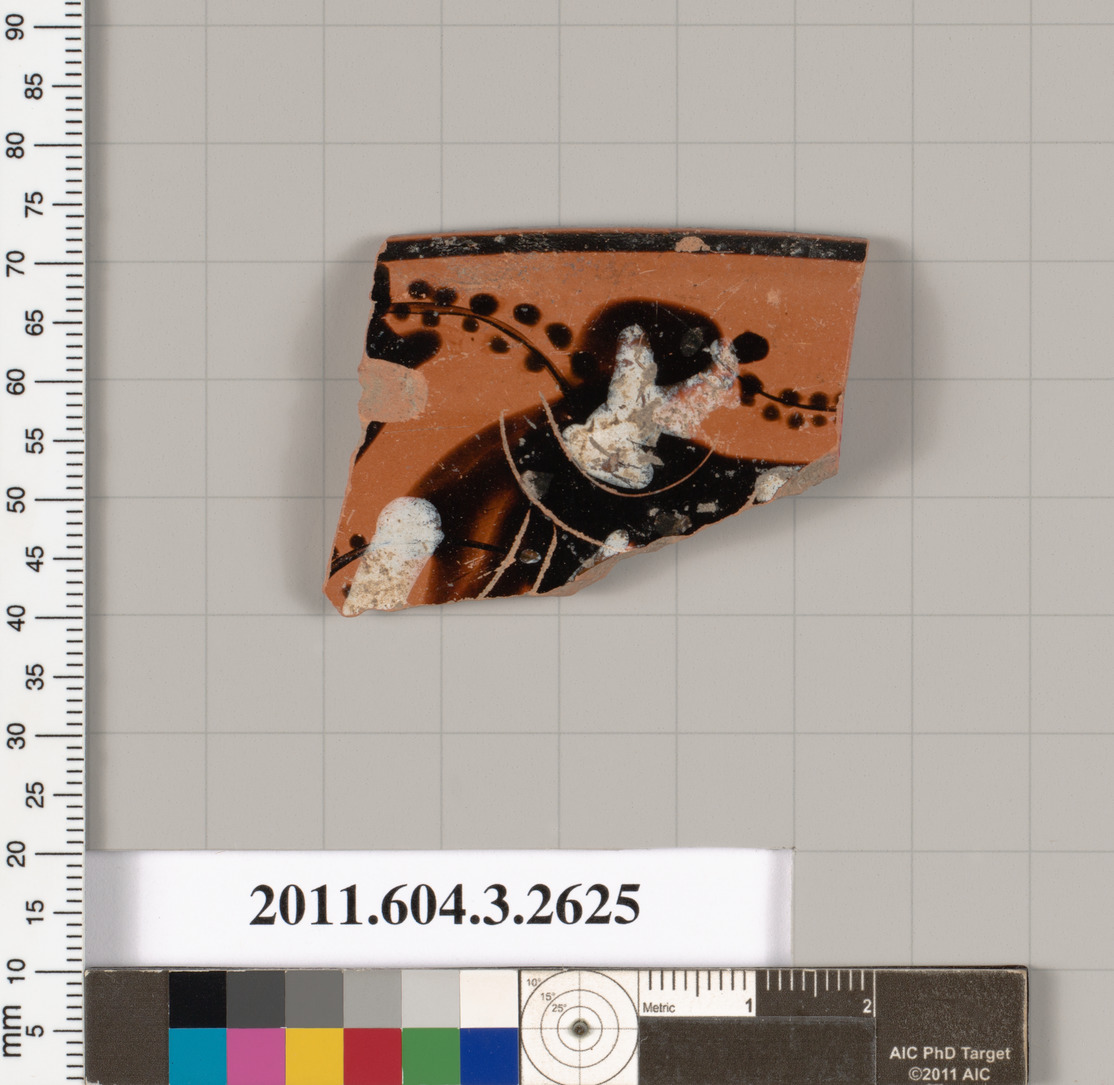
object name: kylix fragment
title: Terracotta rim fragment of a kylix (drinking cup)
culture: greek, attic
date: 525-501 BCE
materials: terracotta